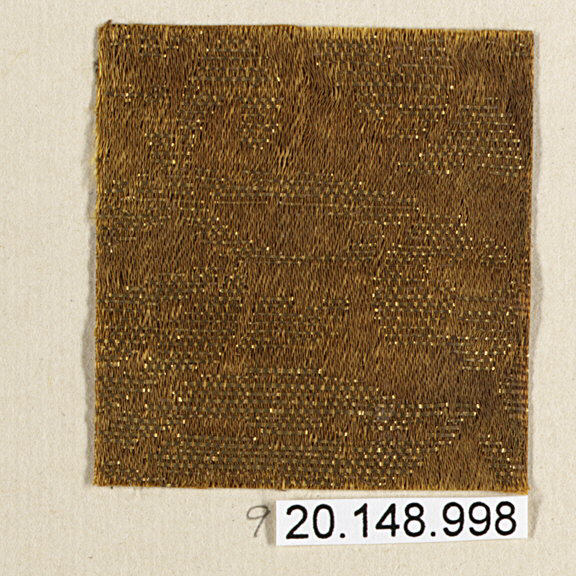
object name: piece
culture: japanese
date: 1701-1800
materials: silk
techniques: compound weave